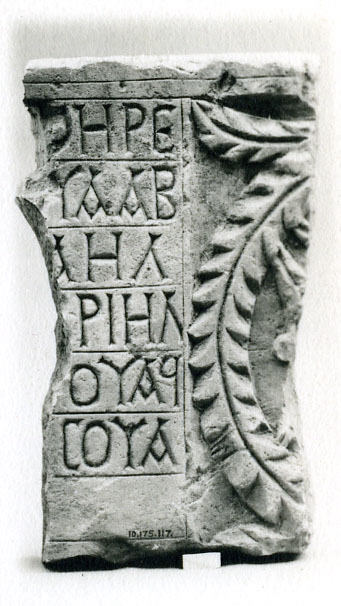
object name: fragment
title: Fragment of an Inscribed Block with a Wreath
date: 501-700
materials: limestone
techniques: carving, incising, relief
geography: egypt